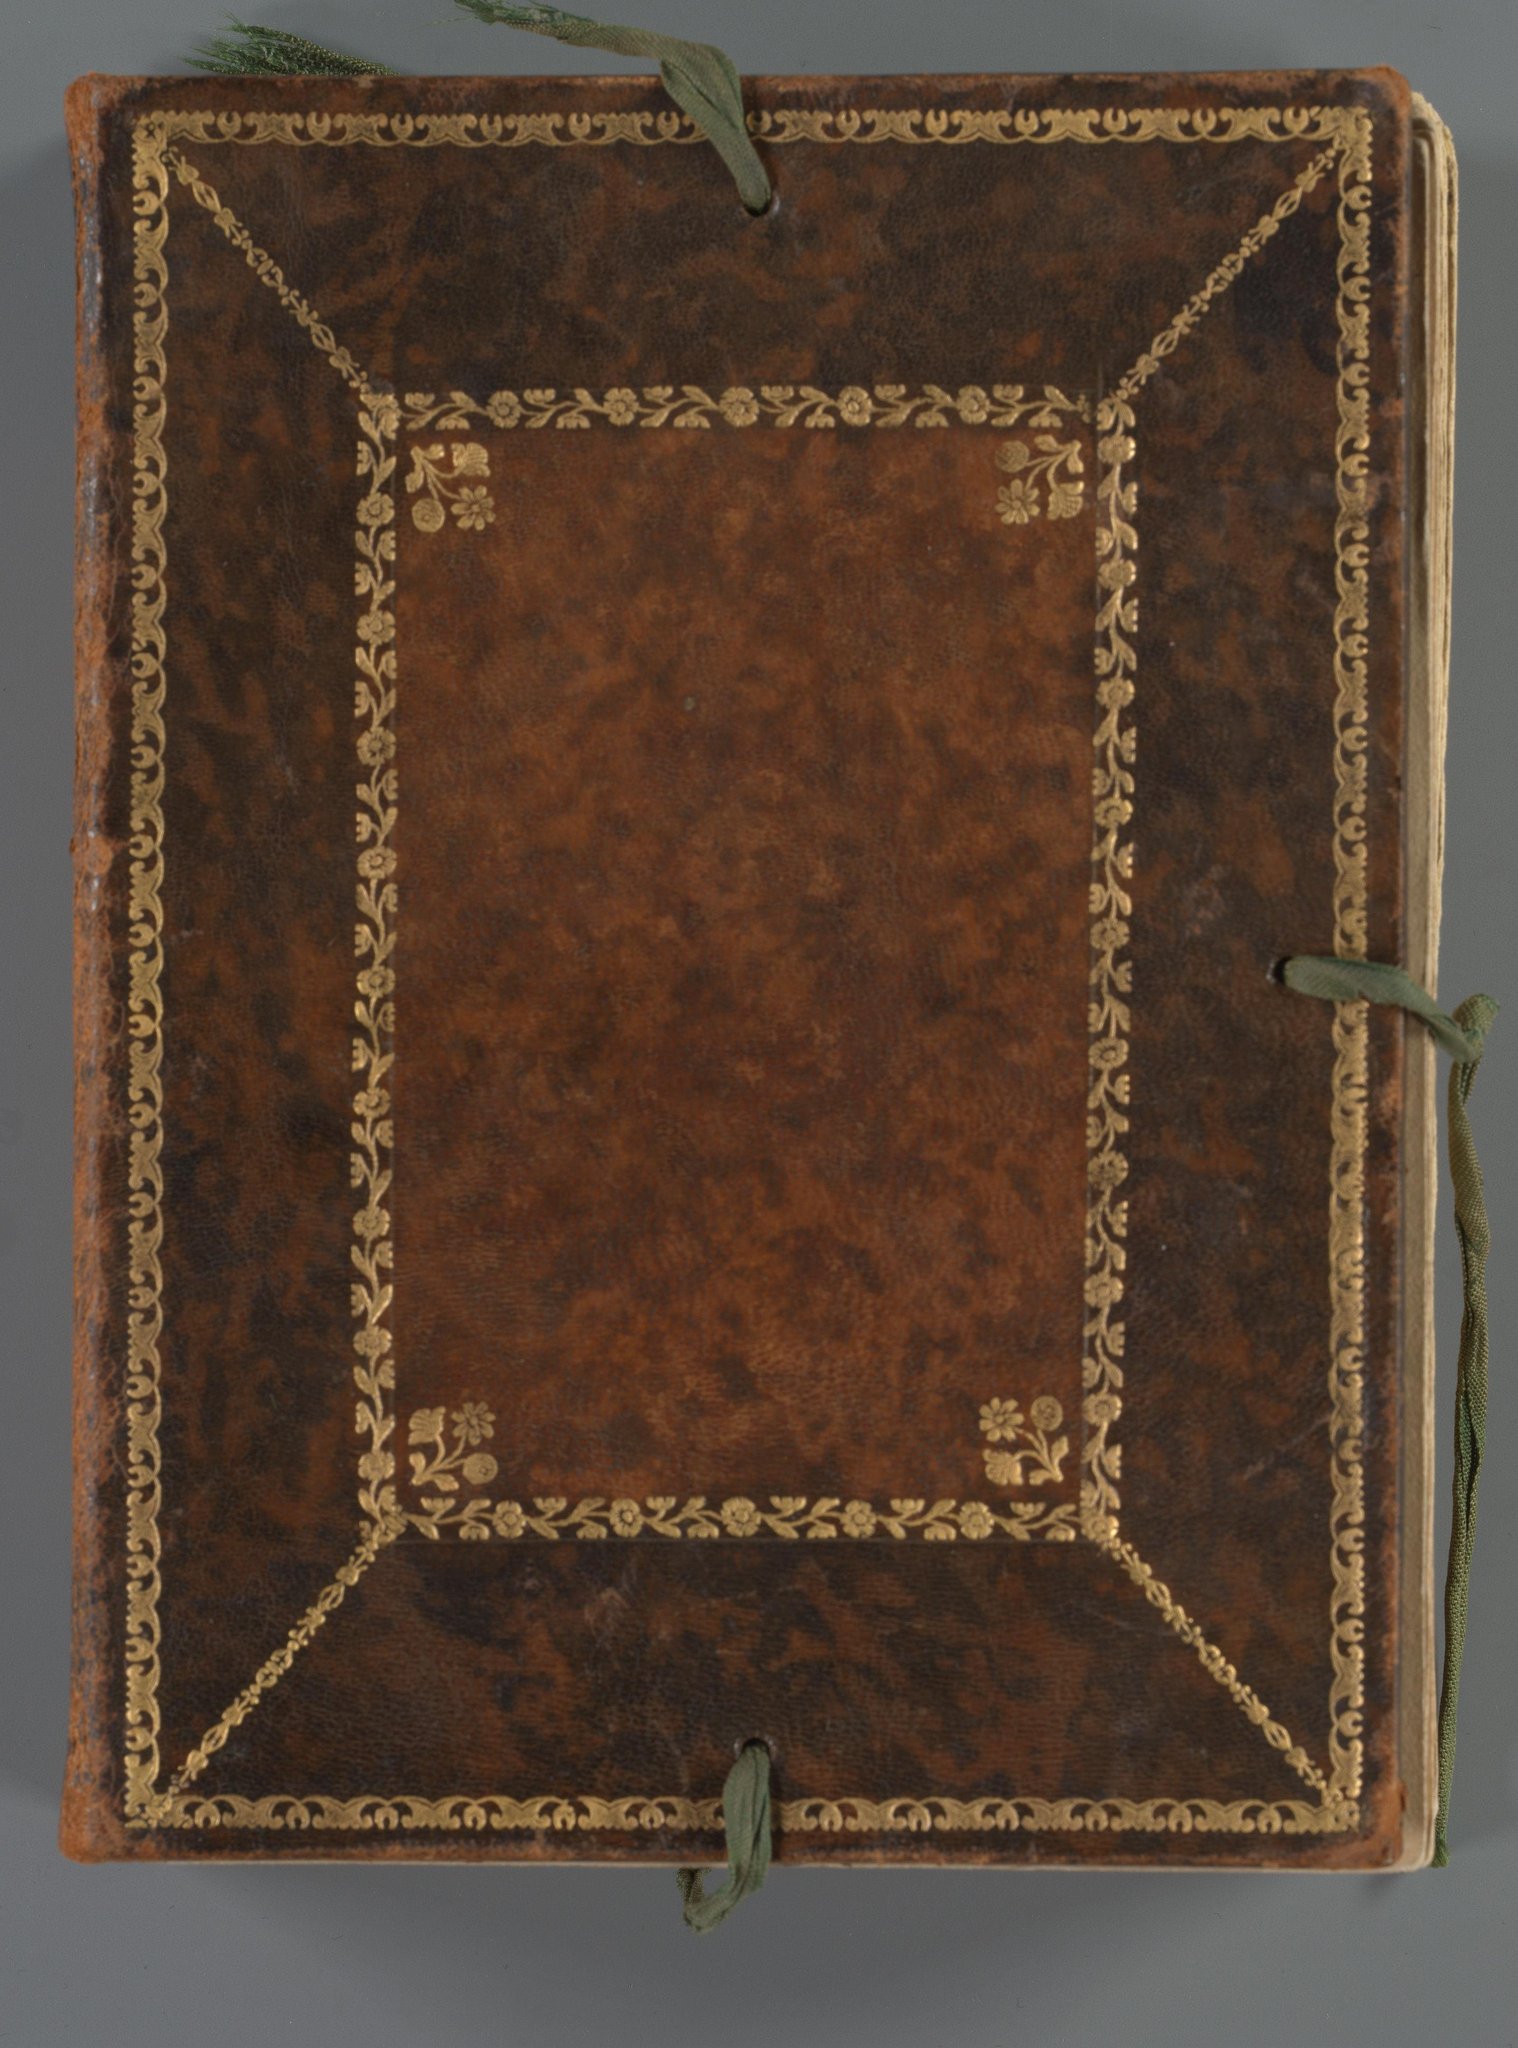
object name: wrapper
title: Omslag voor 105 silhouetportretten van Nederlandse kunstenaars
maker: Anonymous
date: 1800-1849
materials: gold leaf, leather, ribbon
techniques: printing, marbling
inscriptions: collector's mark: Lugt 2228